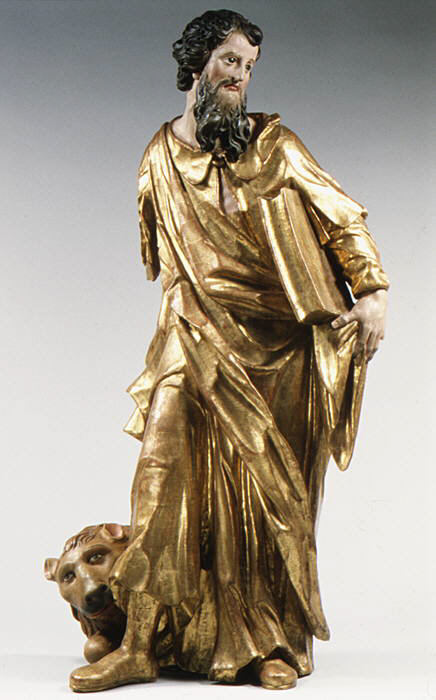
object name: statue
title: Saint Mark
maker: possibly by johann georg libigo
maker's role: artist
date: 1667-1733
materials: wood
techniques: gilding, polychrome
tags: books,lions,saint mark